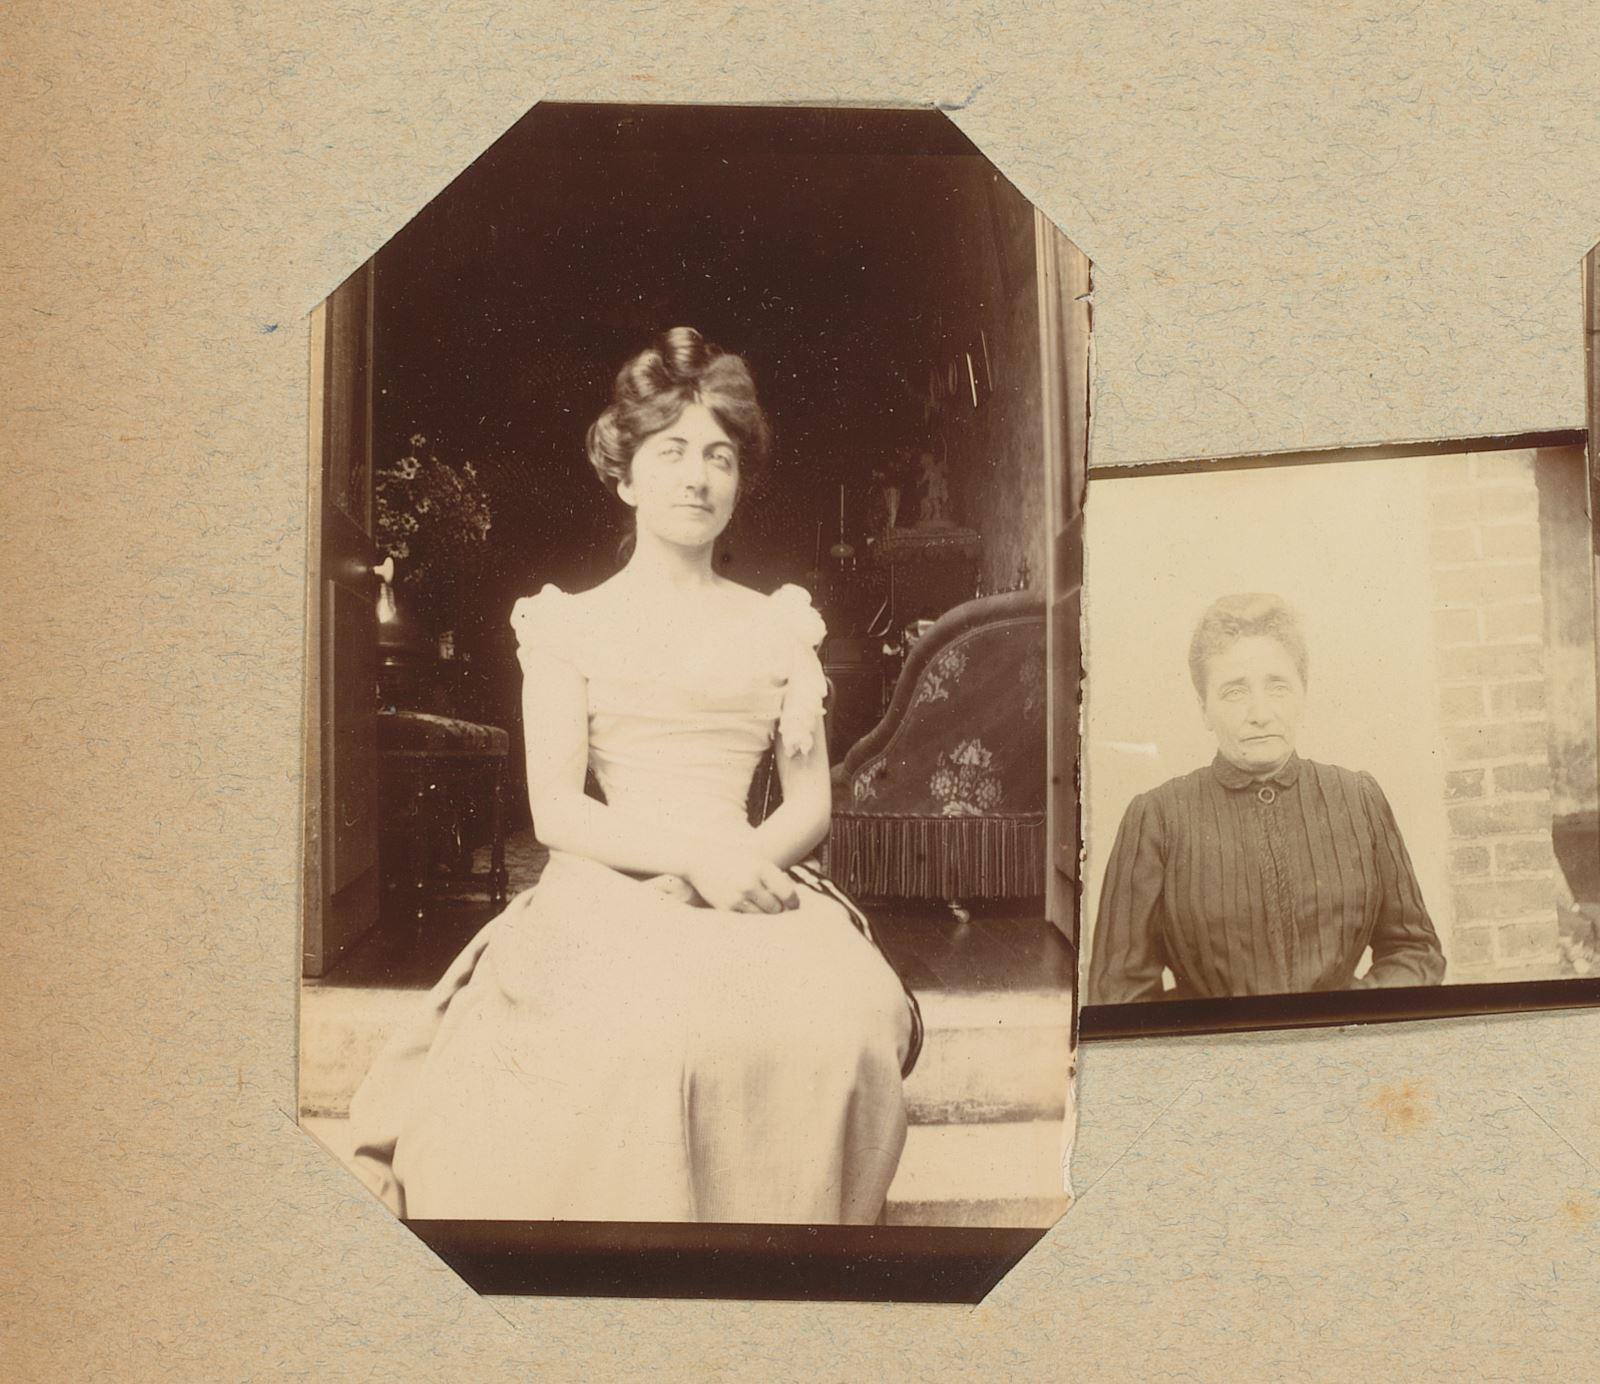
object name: album leaf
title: Portret van een jonge vrouw in jurk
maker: Anonymous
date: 1897-1900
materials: paper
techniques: gelatin silver print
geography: france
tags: adolescent, young woman, maiden, historical persons, france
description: Over de foto is een ander negatief afgedrukt van een voorstelling van bomen.